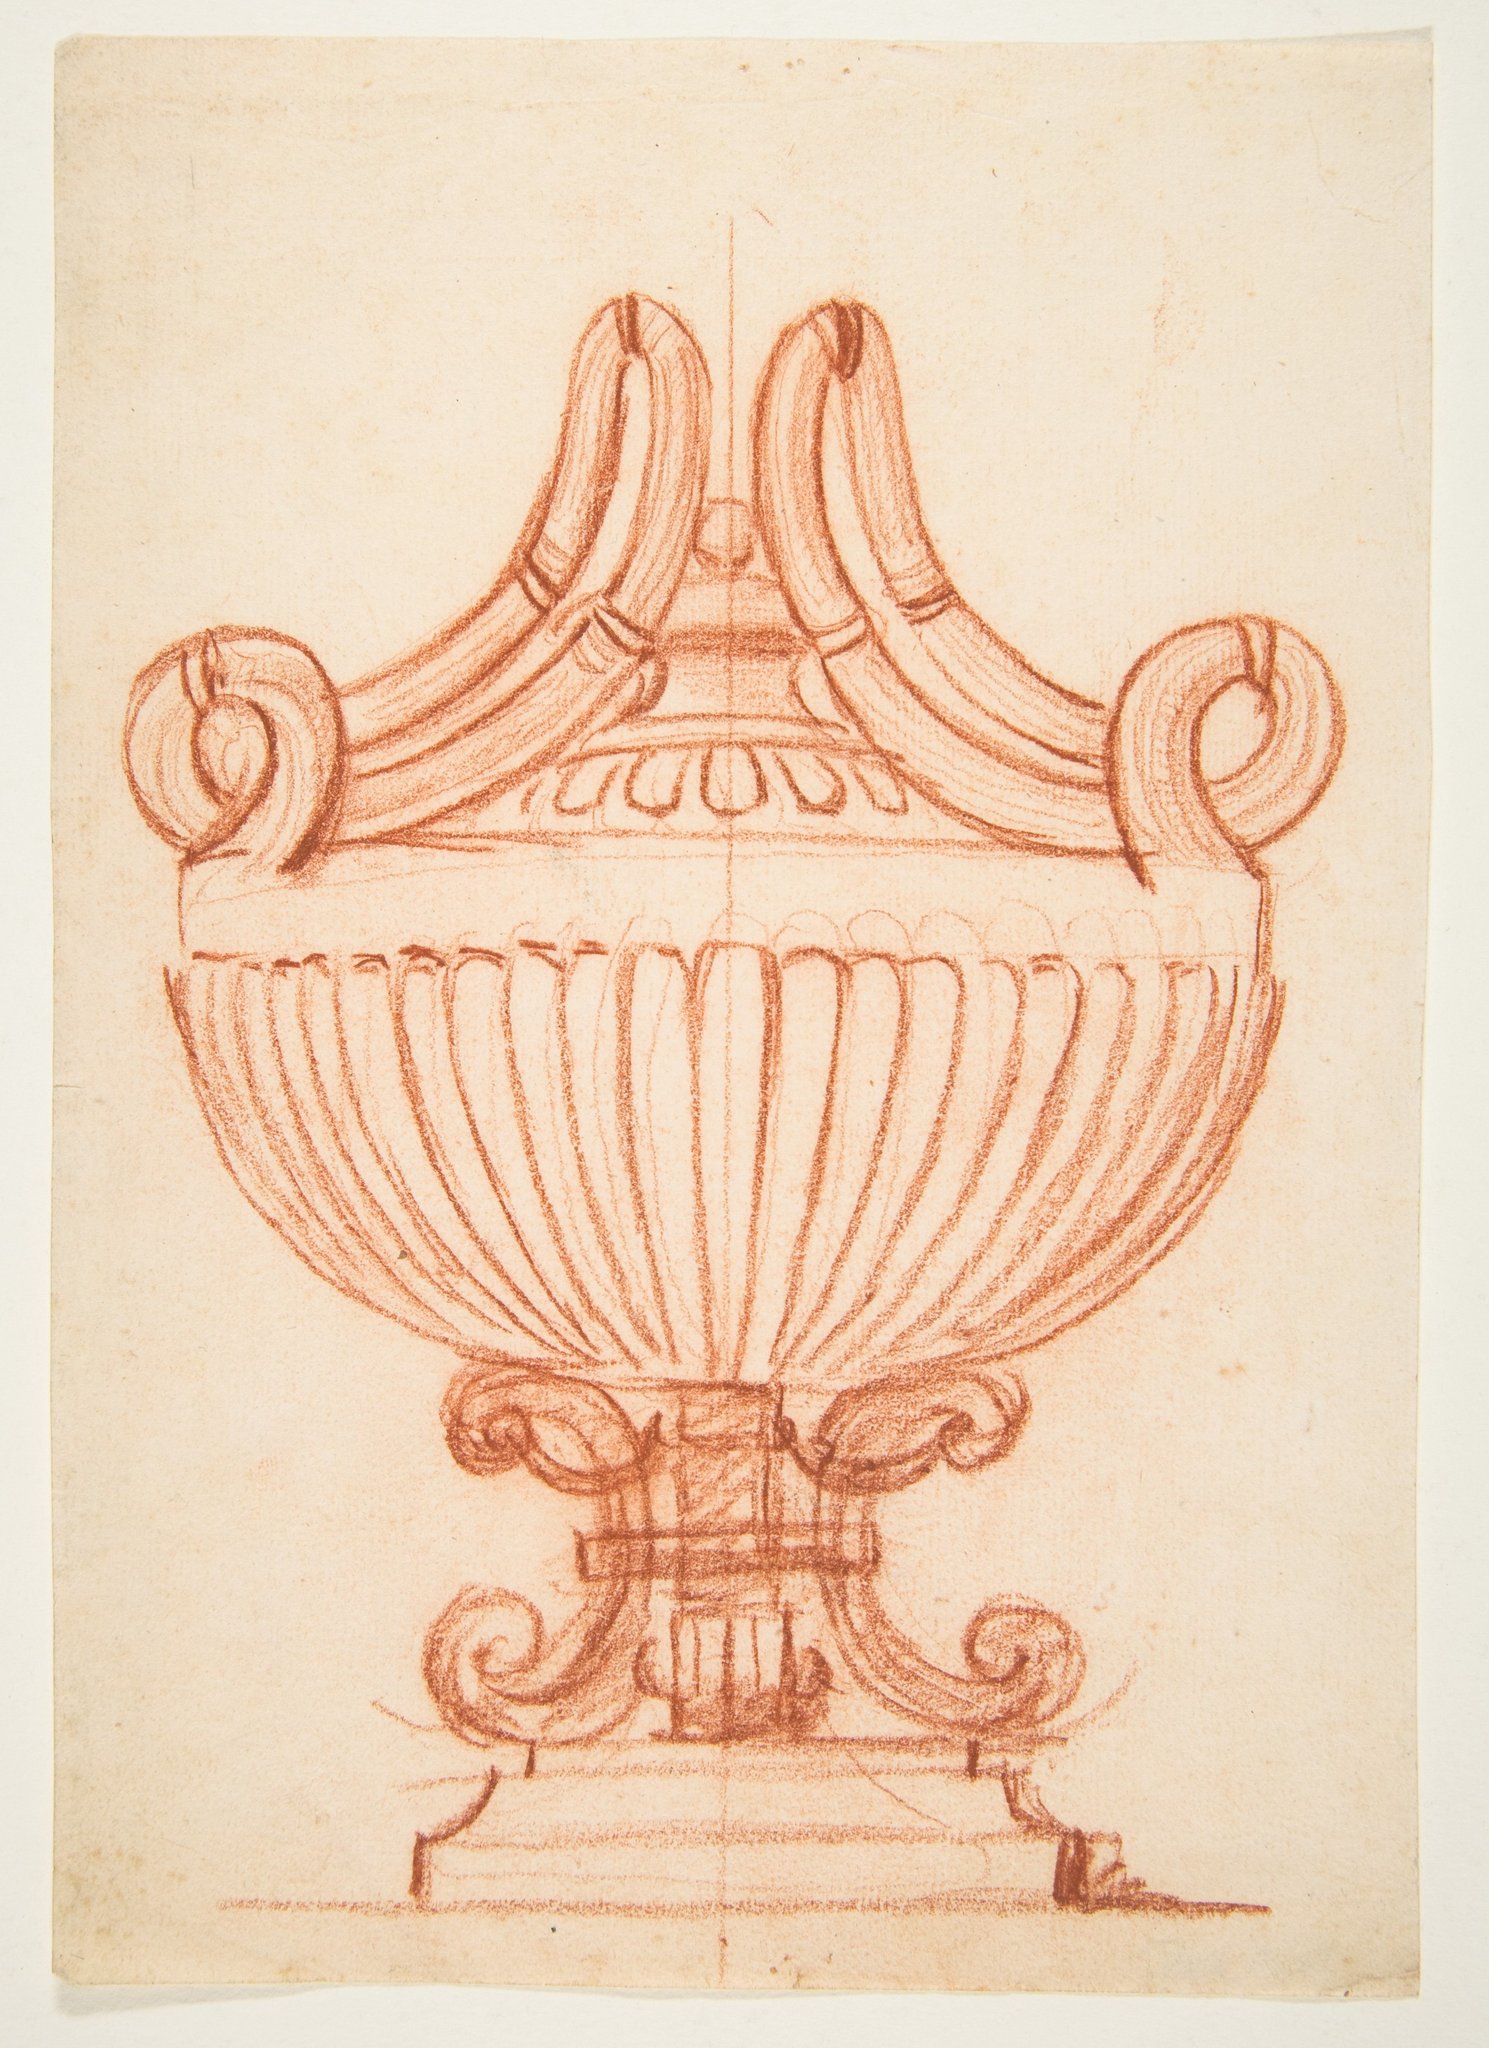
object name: drawing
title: Design for a Covered Vase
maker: anonymous, french, 18th century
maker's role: artist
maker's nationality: french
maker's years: 1700-1800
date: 1701-1800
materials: chalk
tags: vases